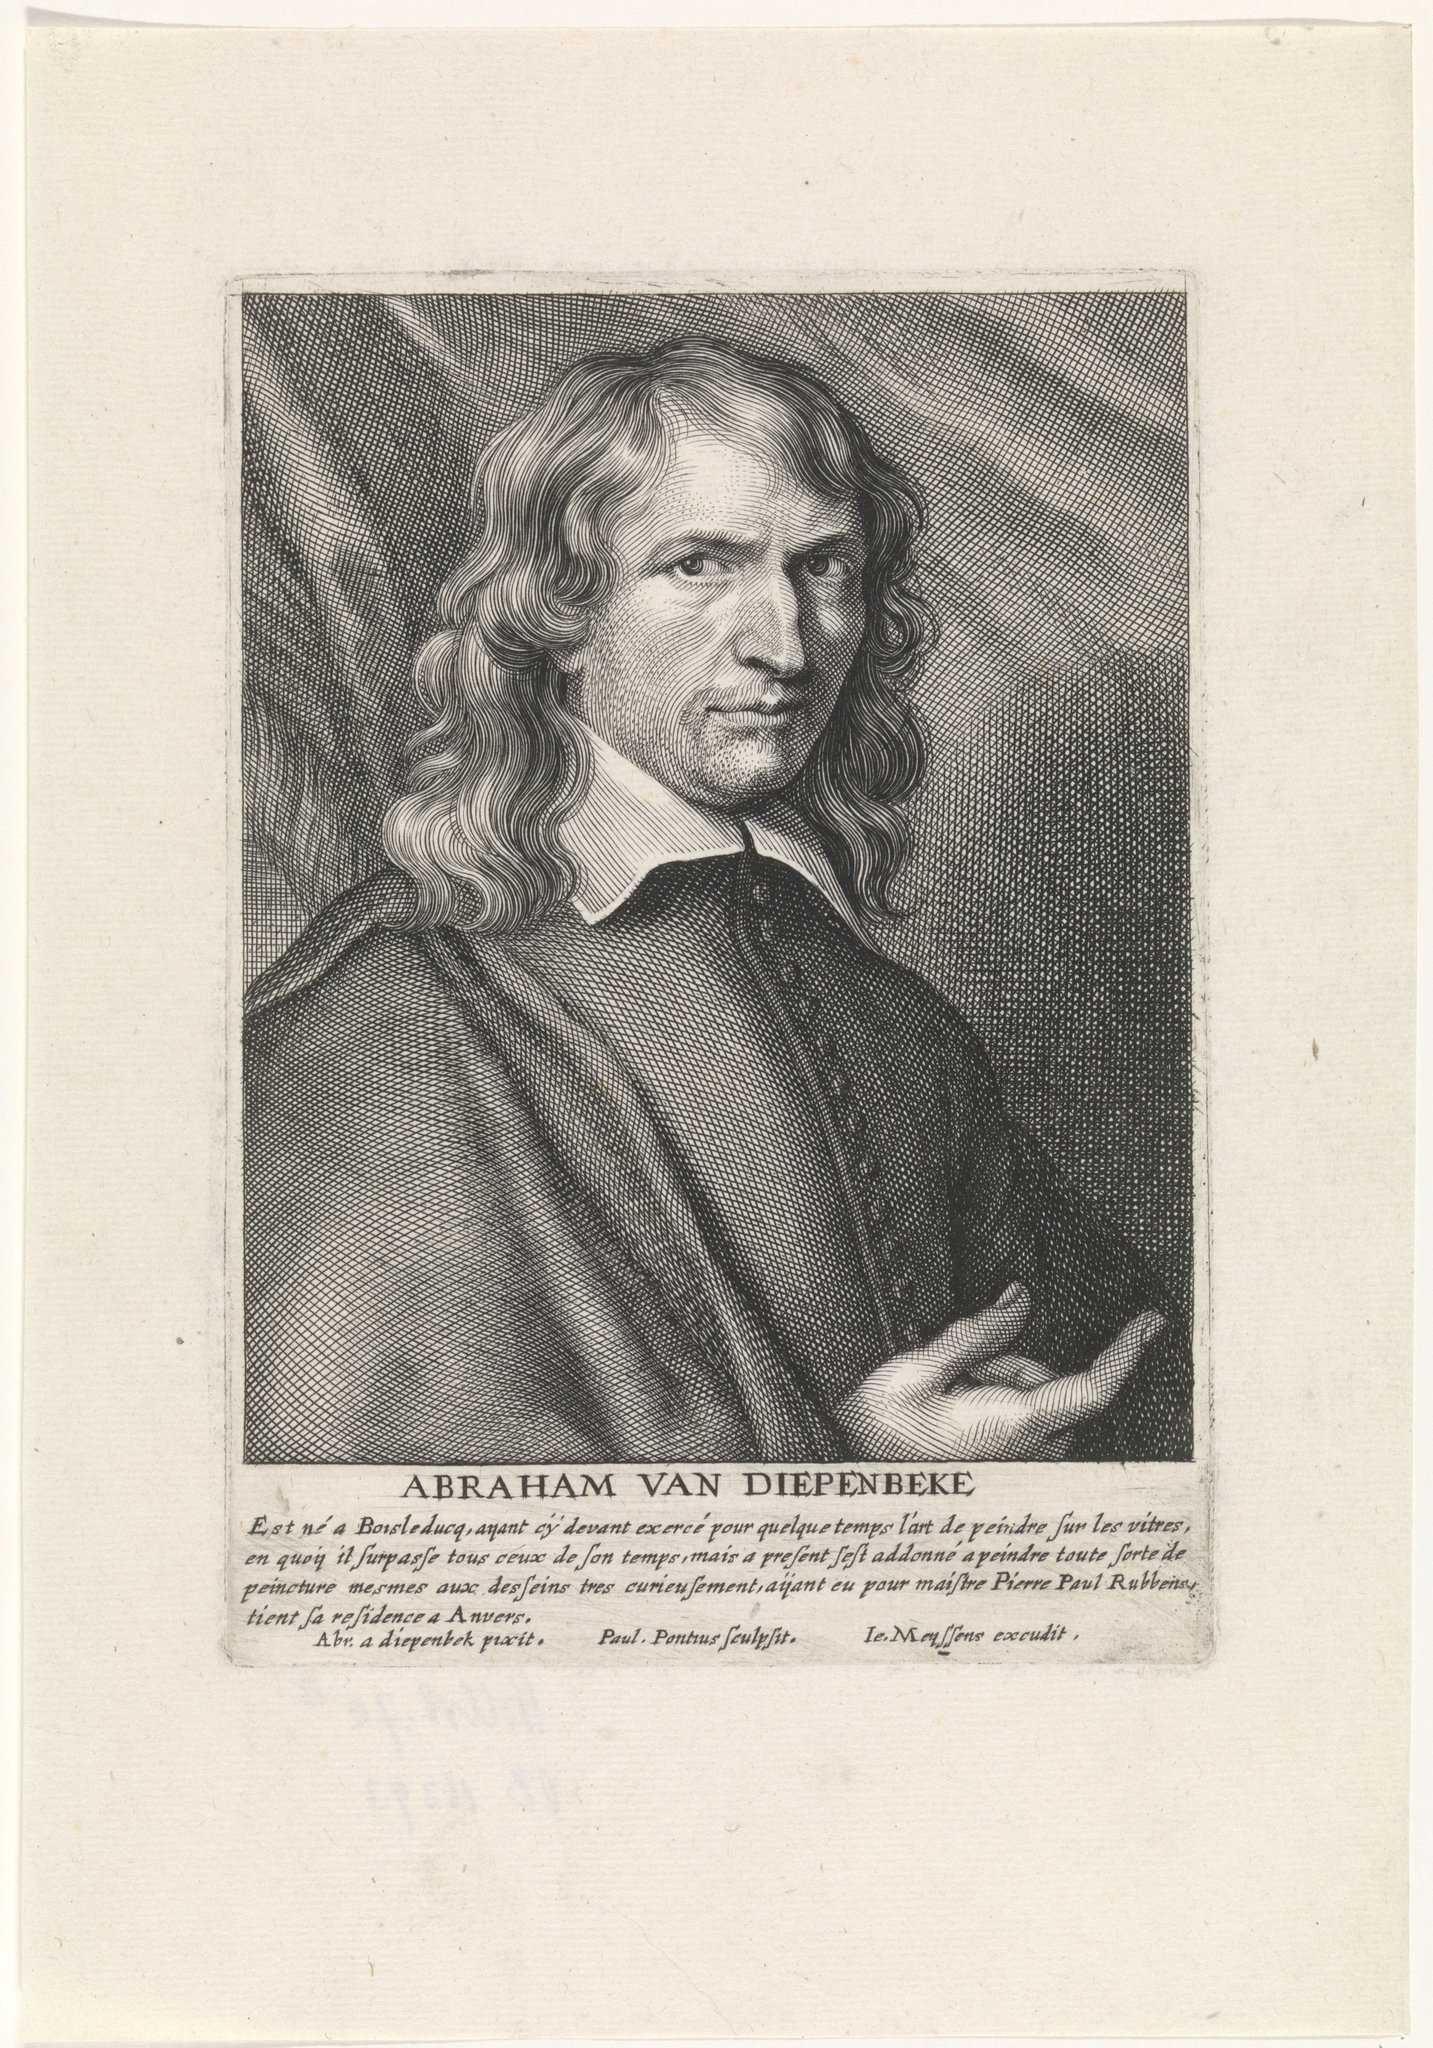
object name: print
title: Portret van de schilder Abraham van Diepenbeeck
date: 1616-1657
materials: paper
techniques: engraving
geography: antwerp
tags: antwerp, draughtsman, abraham van diepenbeeck, portrait, self-portrait of painter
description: Prent ook opgenomen in: Bie, Cornelis de. Het gulden cabinet vande edele vry schilder-const. Antwerpen: Joannes Meyssens, 1662.